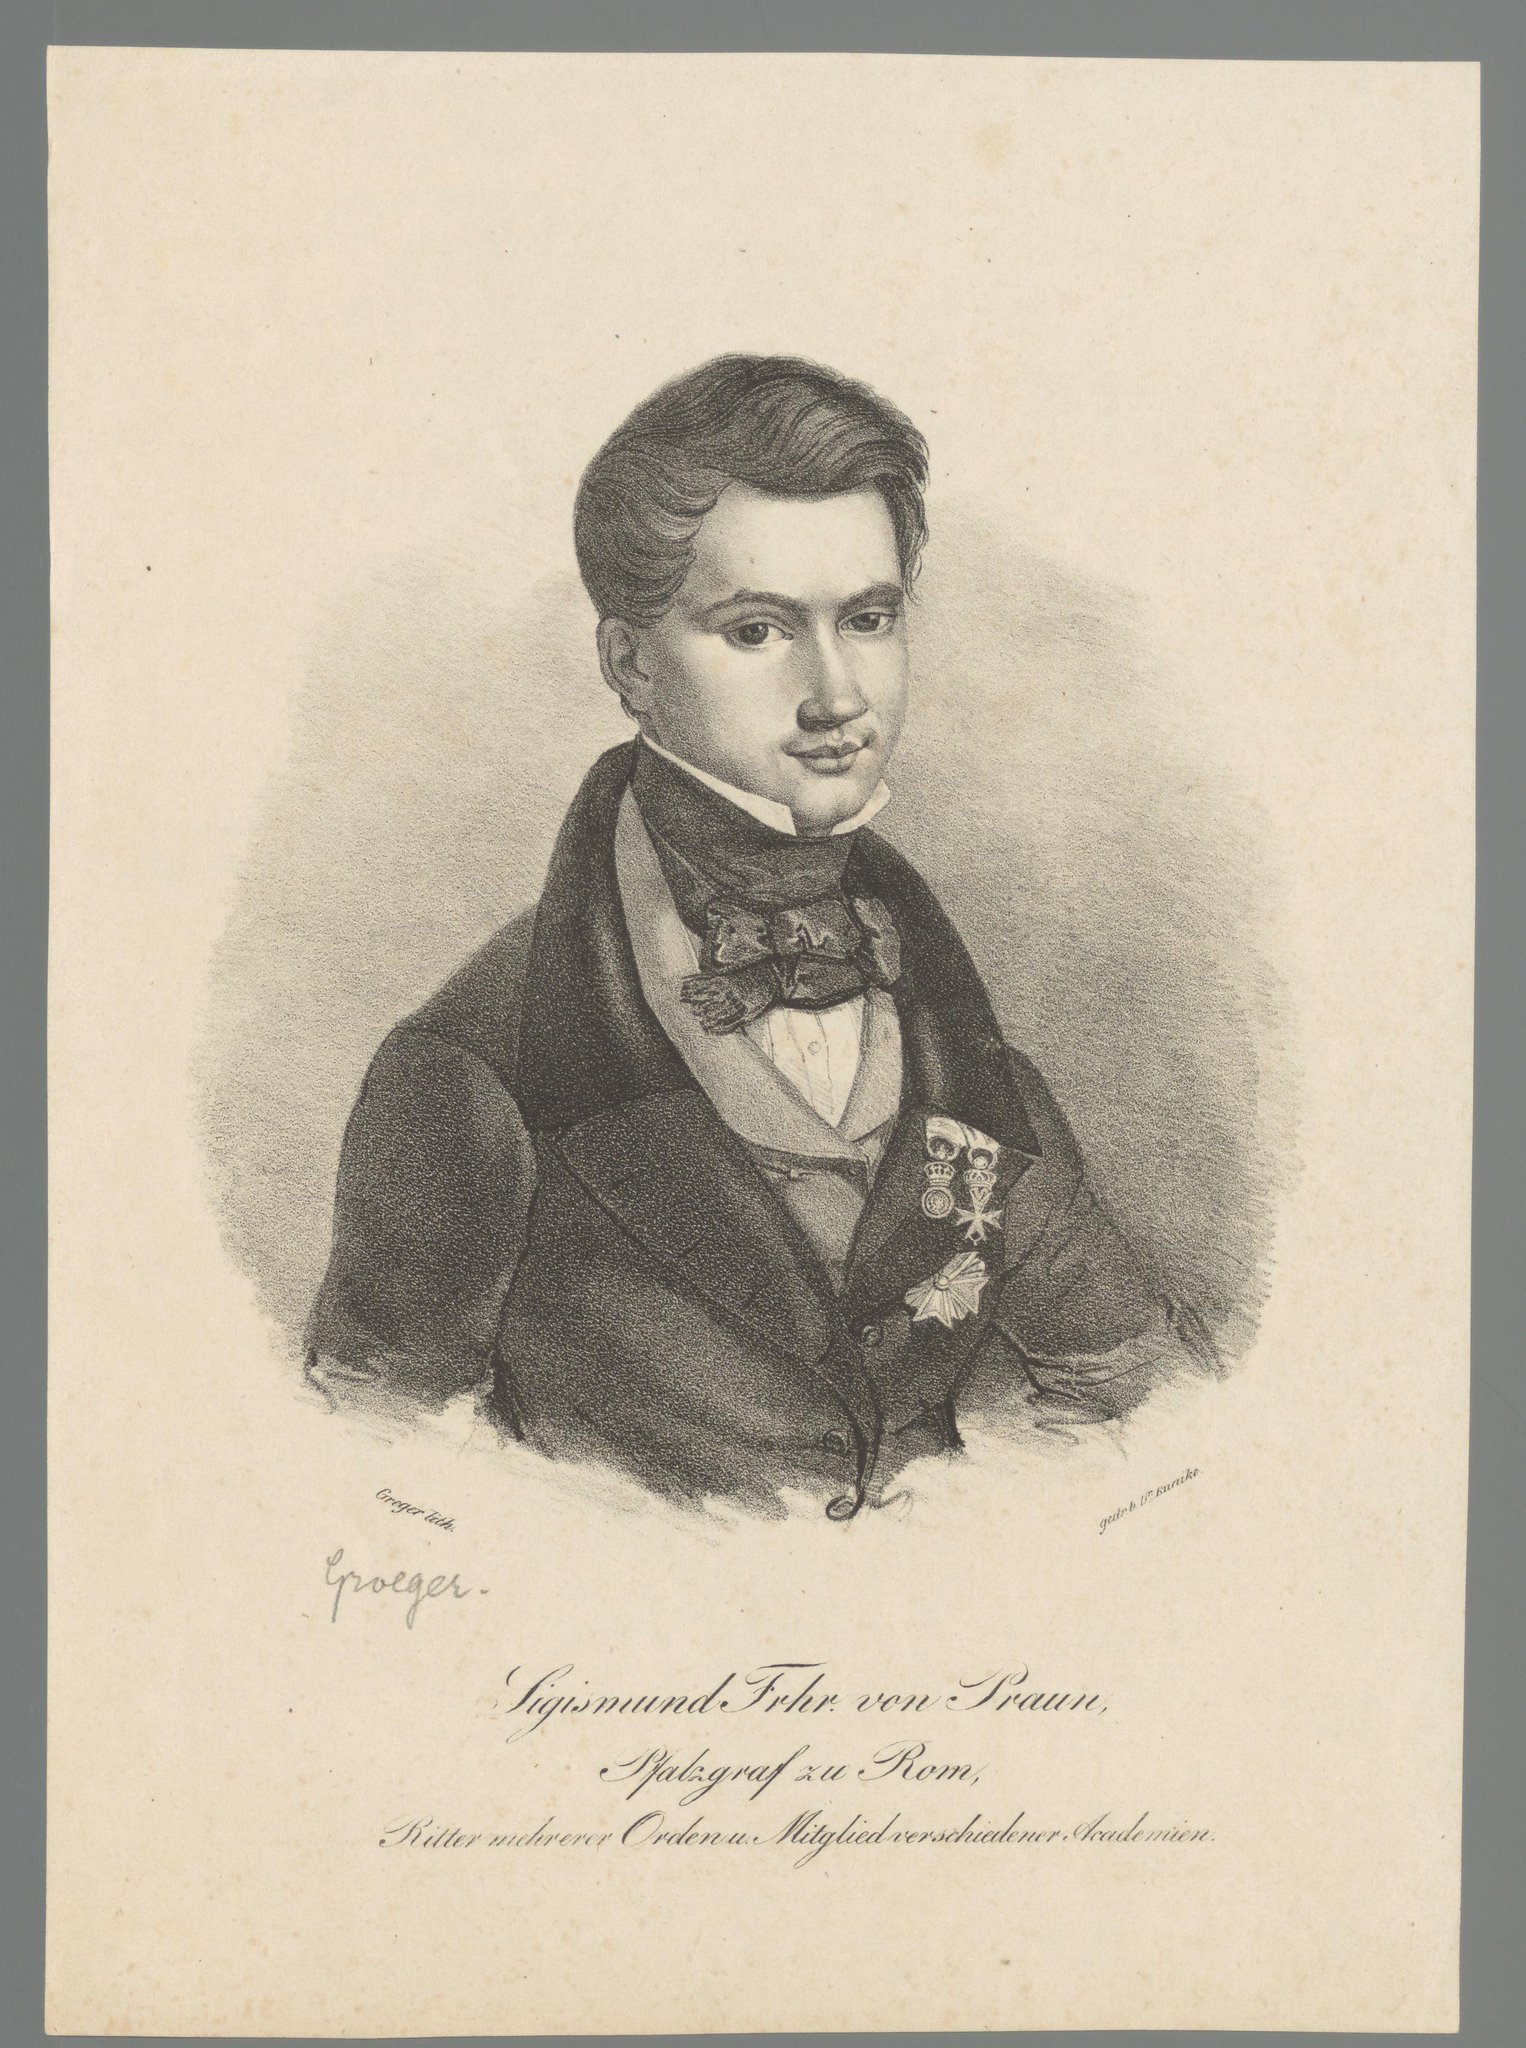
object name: print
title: Sigismund Frhr. von Praun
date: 1820-1838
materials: paper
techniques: lithograph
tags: historical persons, youth, adolescent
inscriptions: collector's mark: Lugt 2228